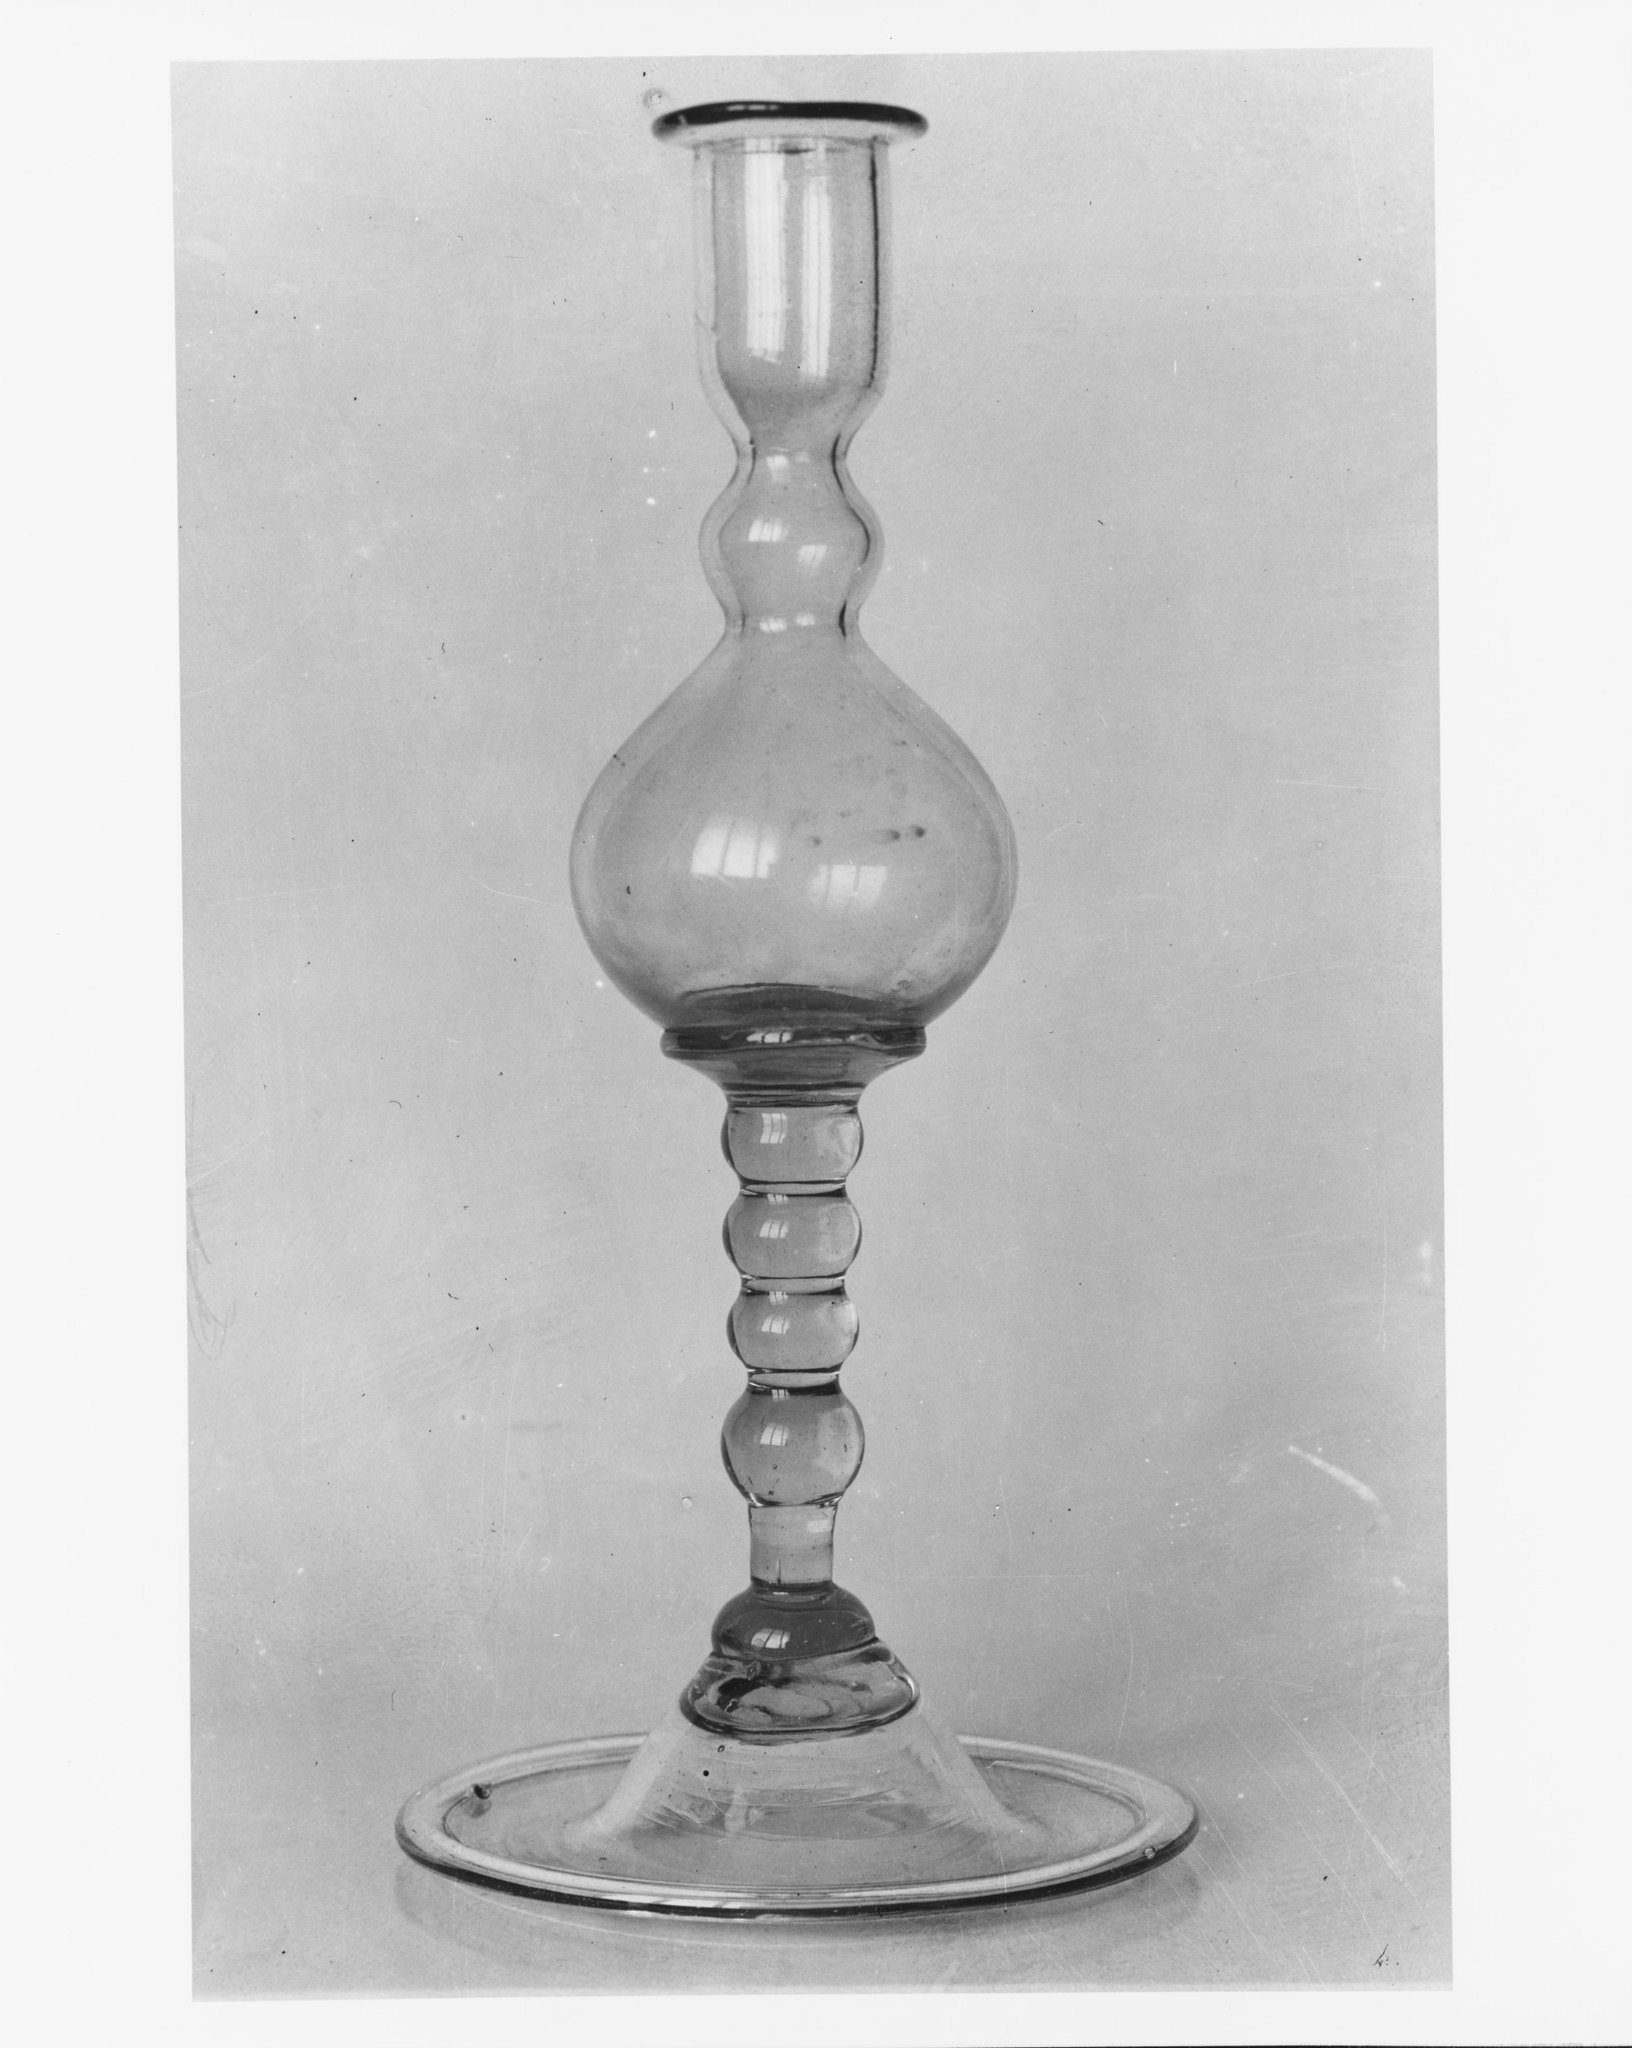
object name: candlestick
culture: american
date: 1700-1800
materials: gemstone, glass, lead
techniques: glassblowing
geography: united states